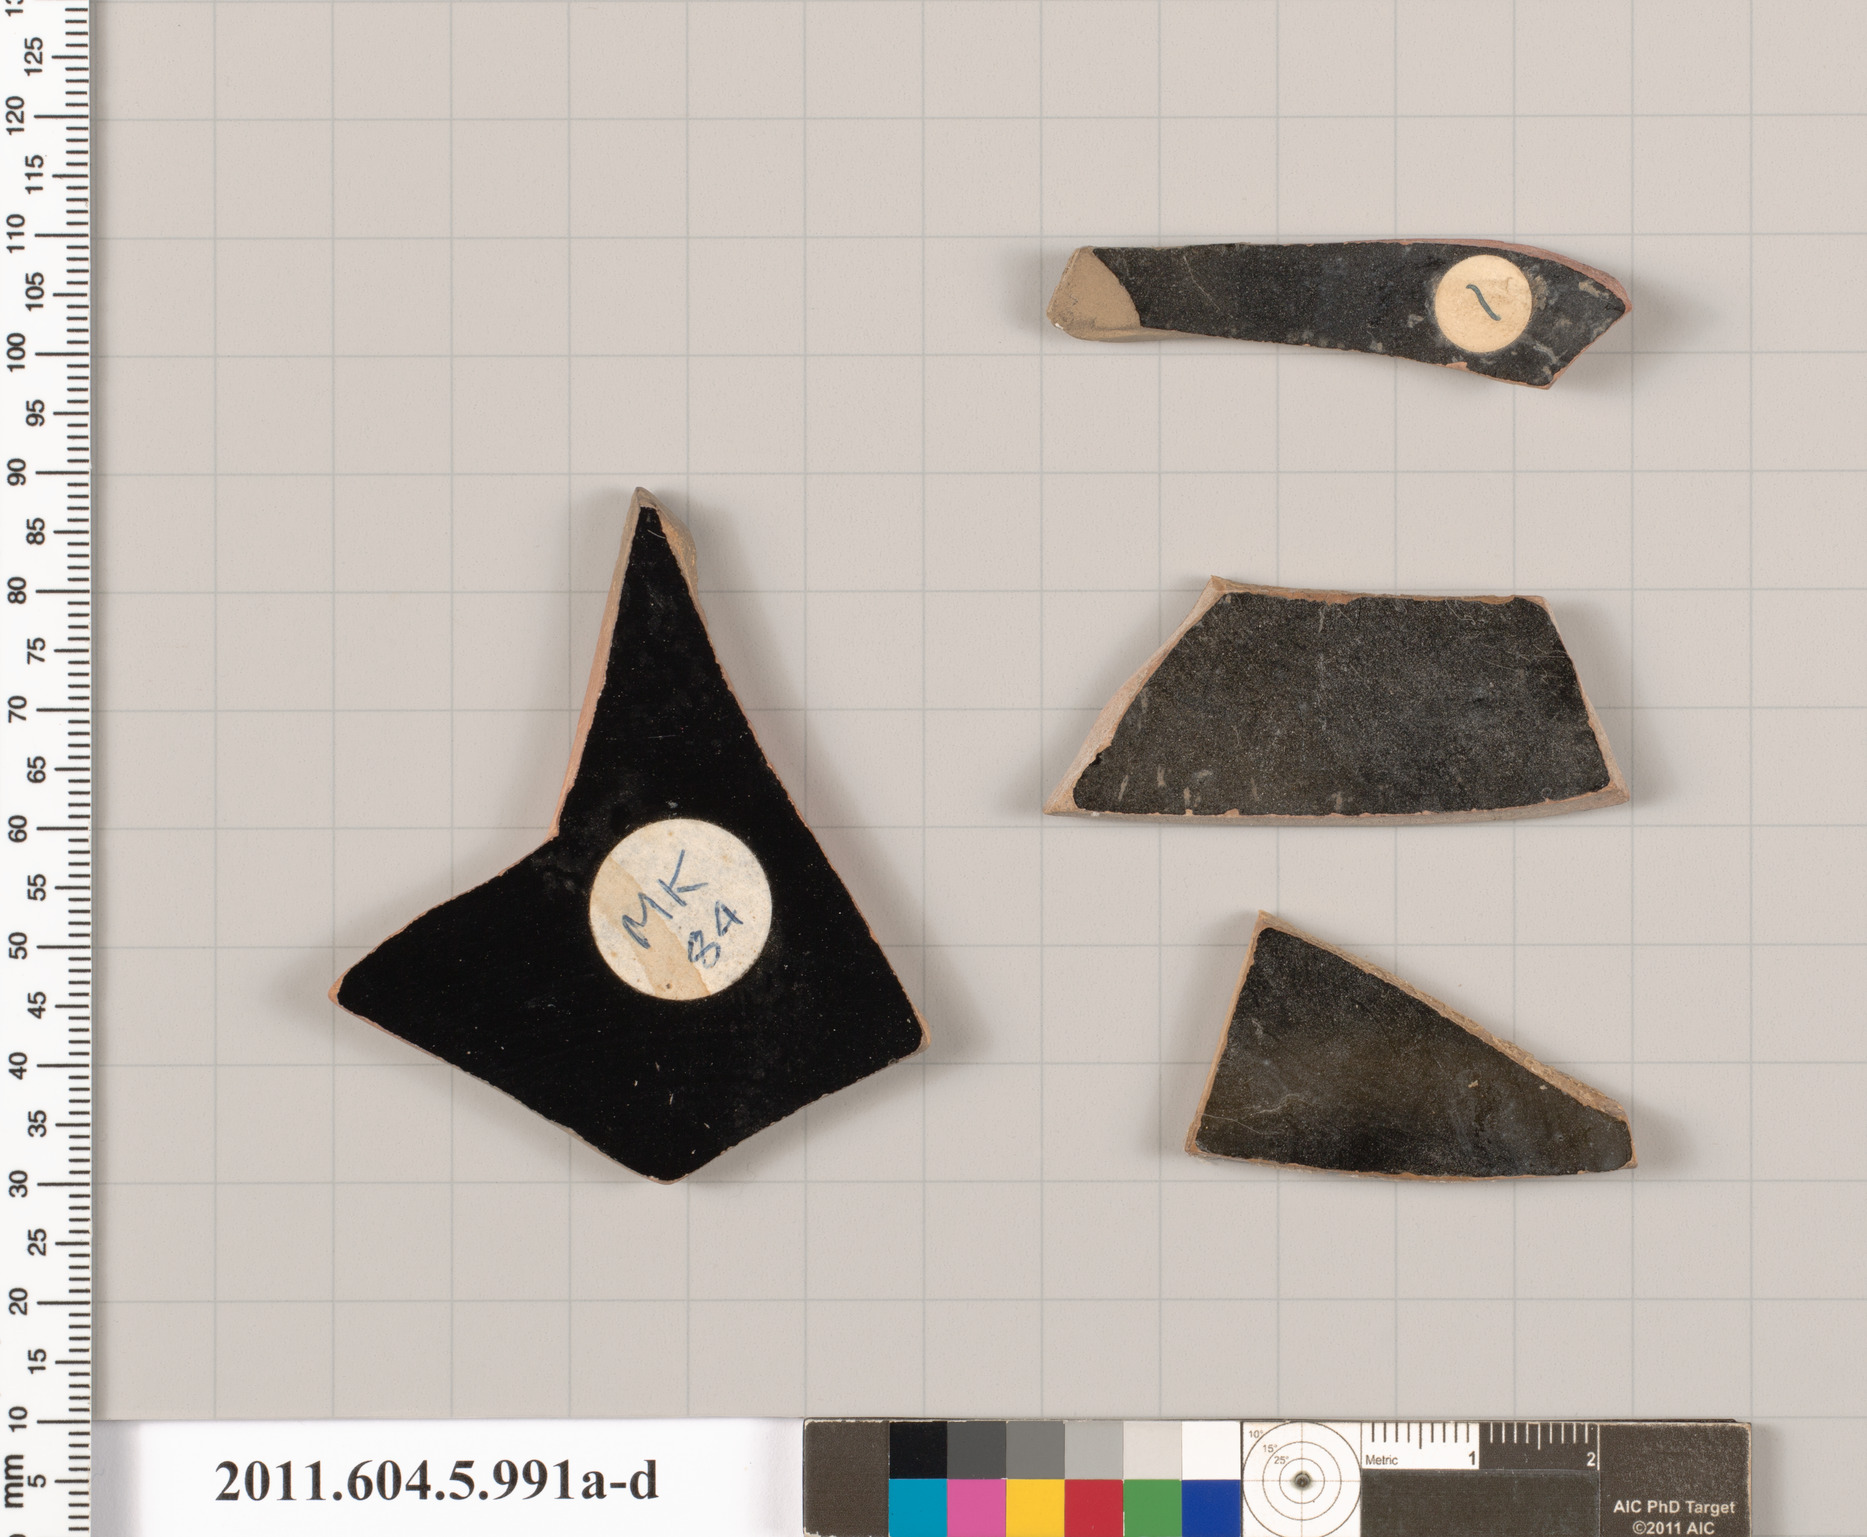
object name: kylix fragment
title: Terracotta fragments of kylikes (drinking cups)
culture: greek, attic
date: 600-401 BCE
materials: terracotta